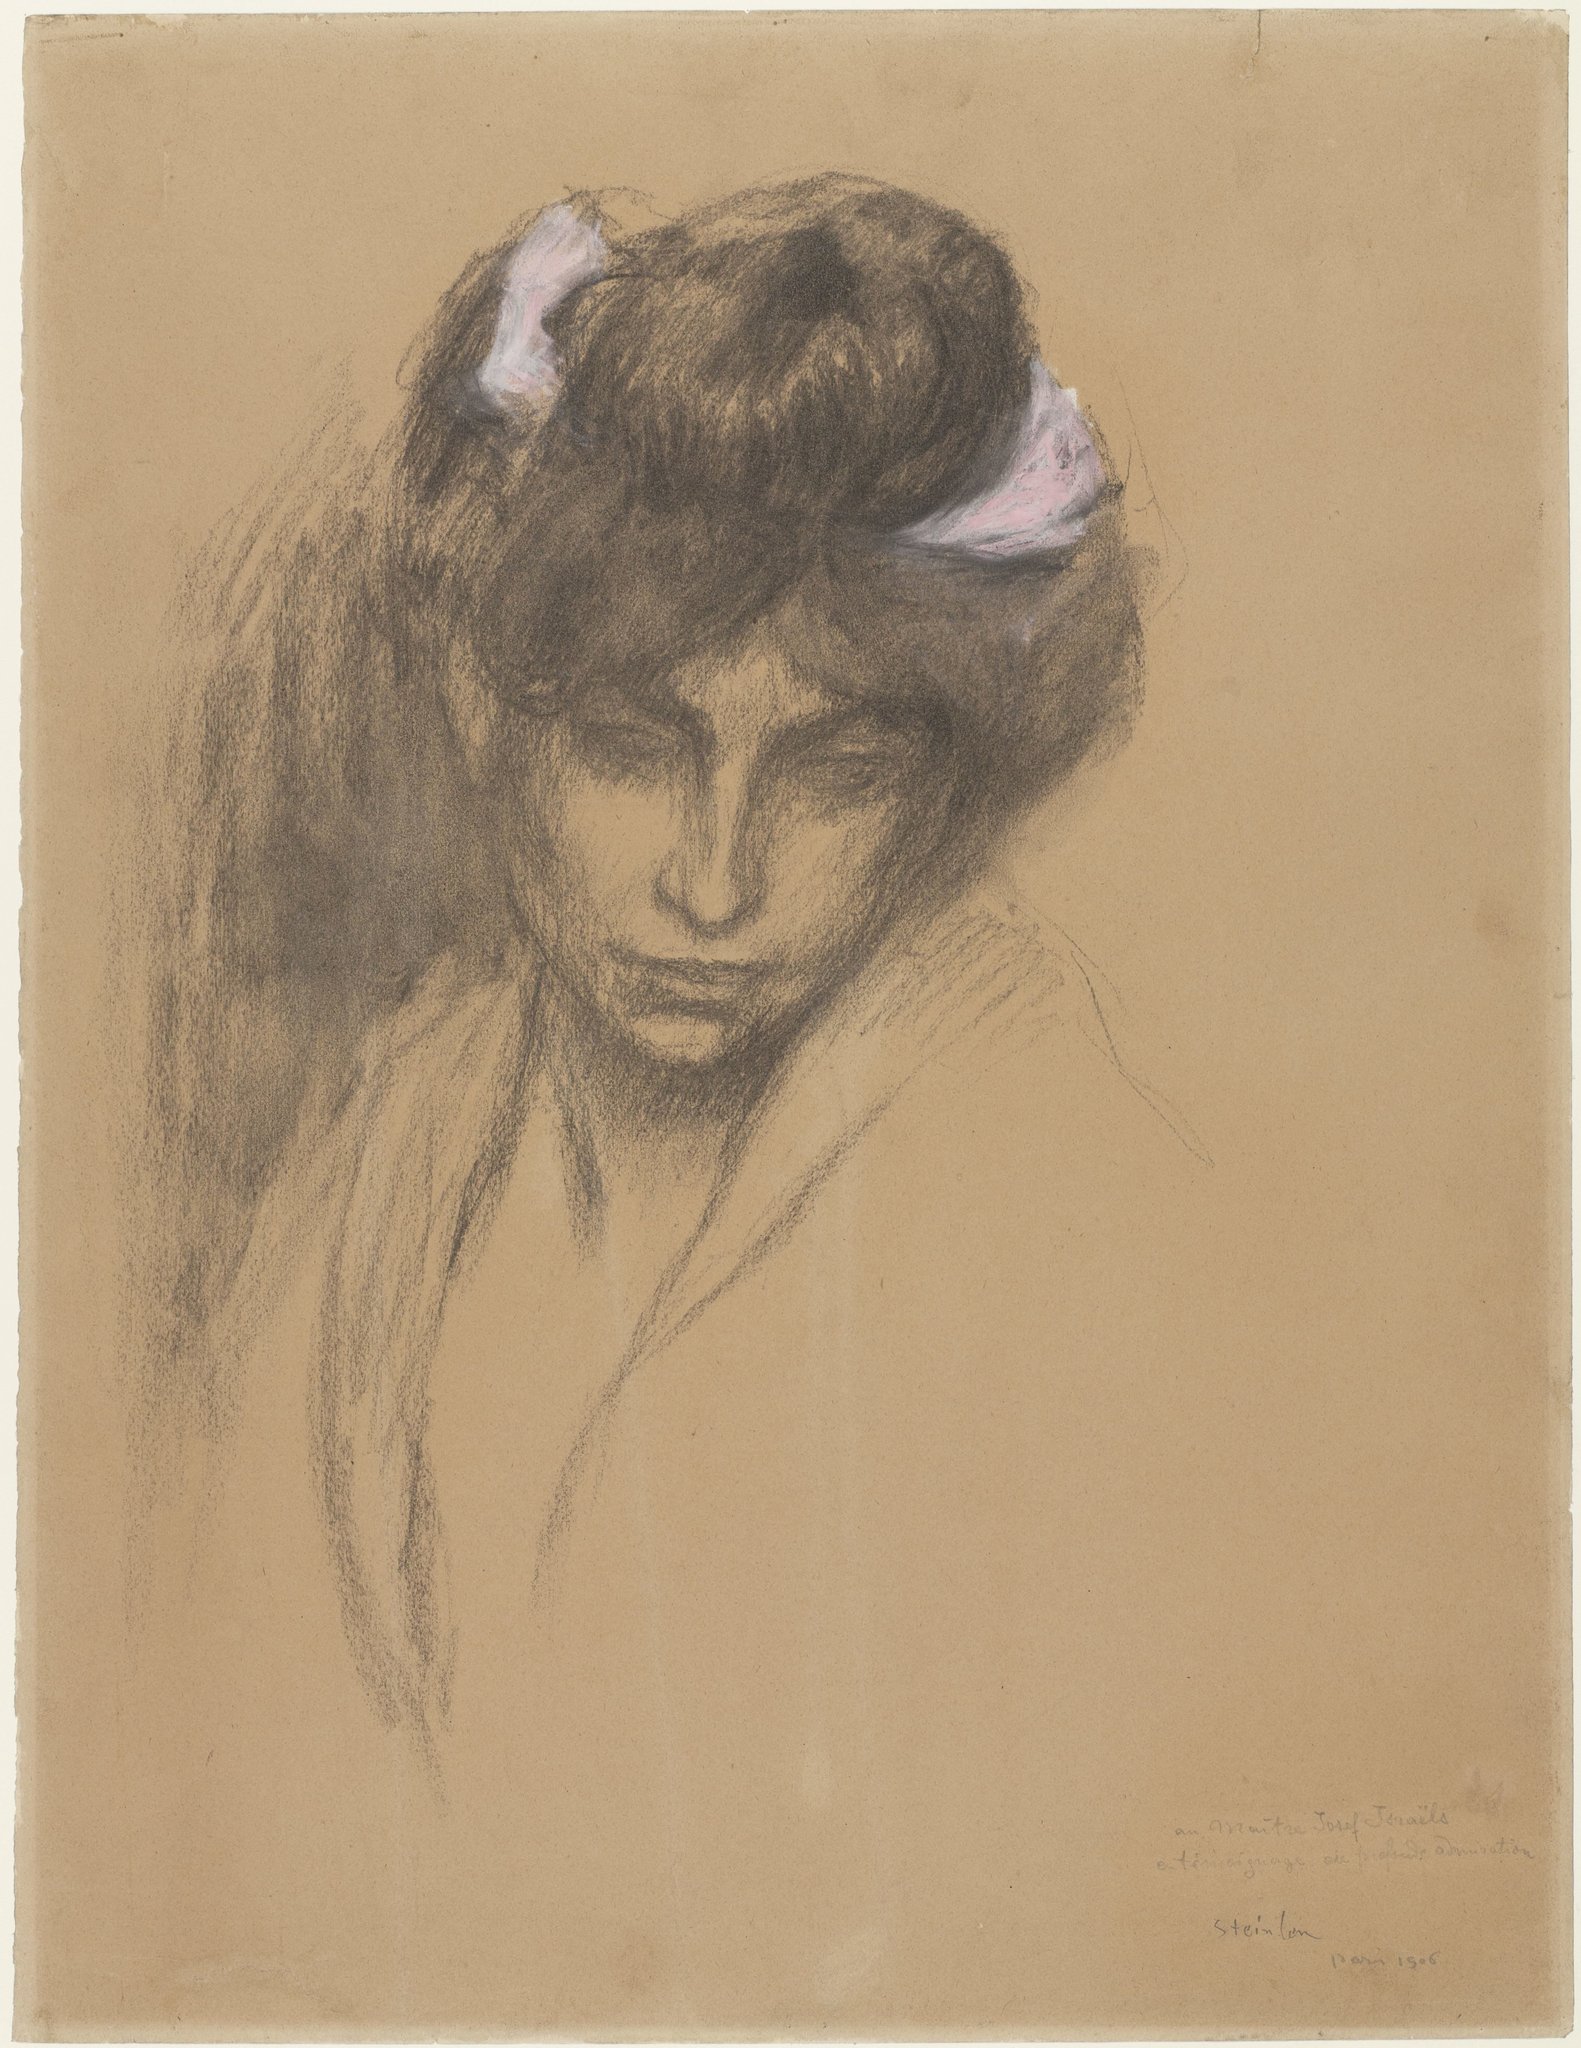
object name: drawing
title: Donker meisjeskopje, naar voren neerziend, met een paars lint in het haar gewonden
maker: théophile alexandre steinlen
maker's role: draughtsman, painter, print maker, sculptor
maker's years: 1859-1923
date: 1906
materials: charcoal, paper, pastel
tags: adolescent, young woman, maiden, historical persons not known by name - bb - woman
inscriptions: date: ‘1906’